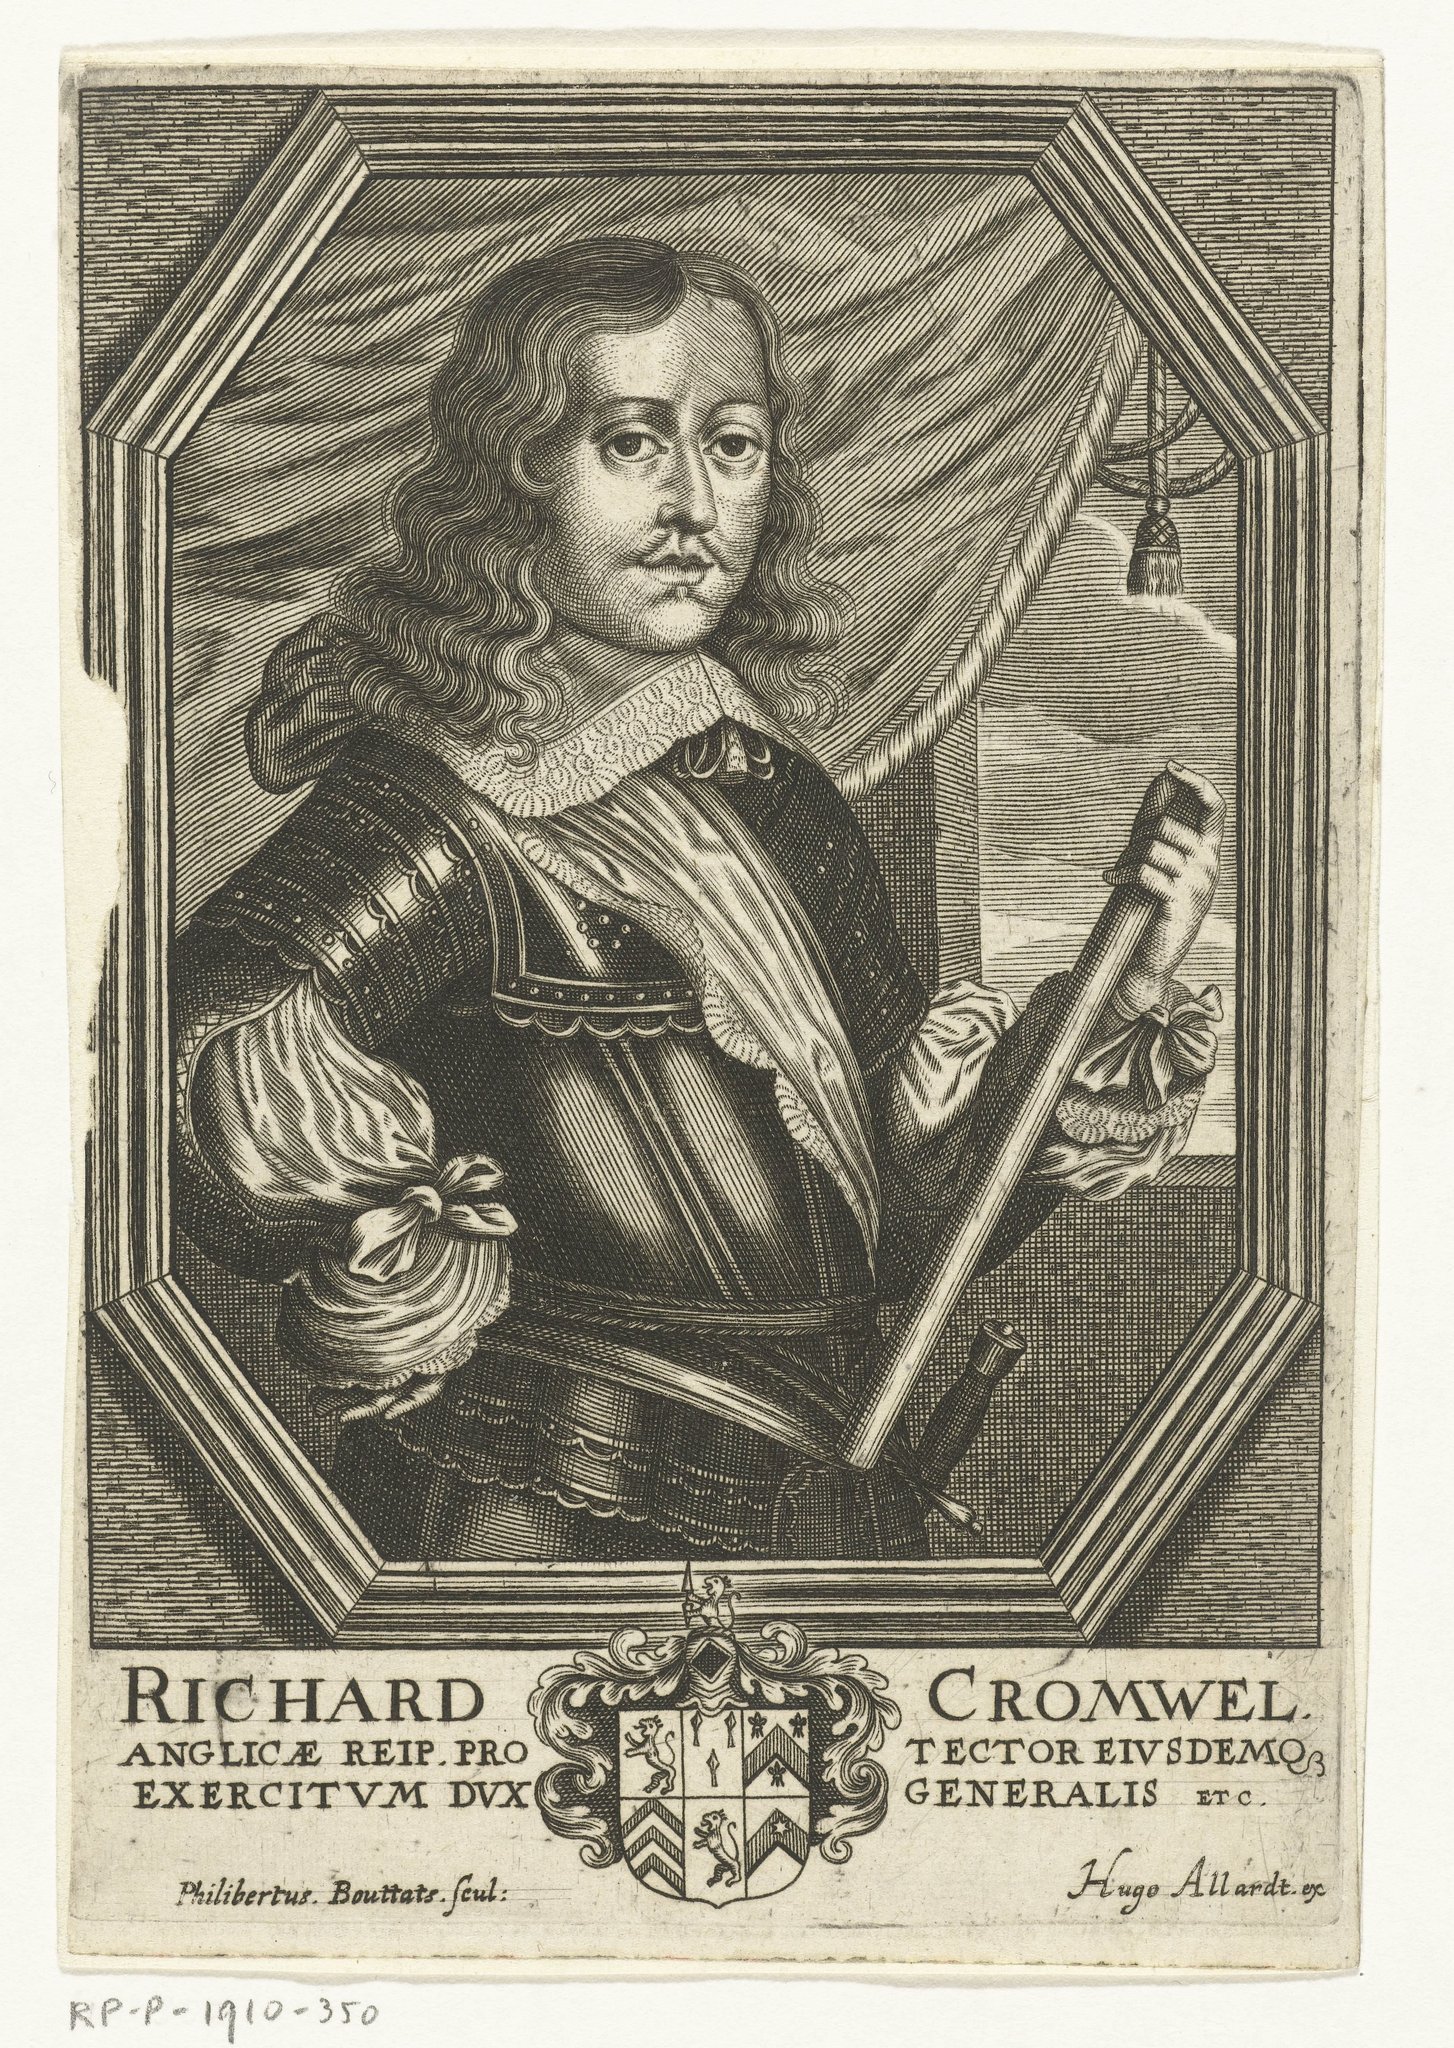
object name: print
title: Portret van Richard Cromwell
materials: paper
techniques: engraving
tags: cheshunt, historical persons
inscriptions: collector's mark: Lugt 2228, address: ‘Hugo Allardt ex.’, title: ‘RICHARD CROMWELL....Dux Generalis etc.’, signature: ‘Philibertus Bouttats scul:’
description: Portret van Richard Cromwell, de derde zoon van Oliver Cromwell en 'Lord Protector' van Engeland, Schotland en Ierland, in octagonale lijst. Portret ten halven lijve, naar rechts. Richard Cromwell draagt een harnas en in zijn linkerhand heeft hij een batton. Wapen middenonder. De prent heeft een Latijns onderschrift.